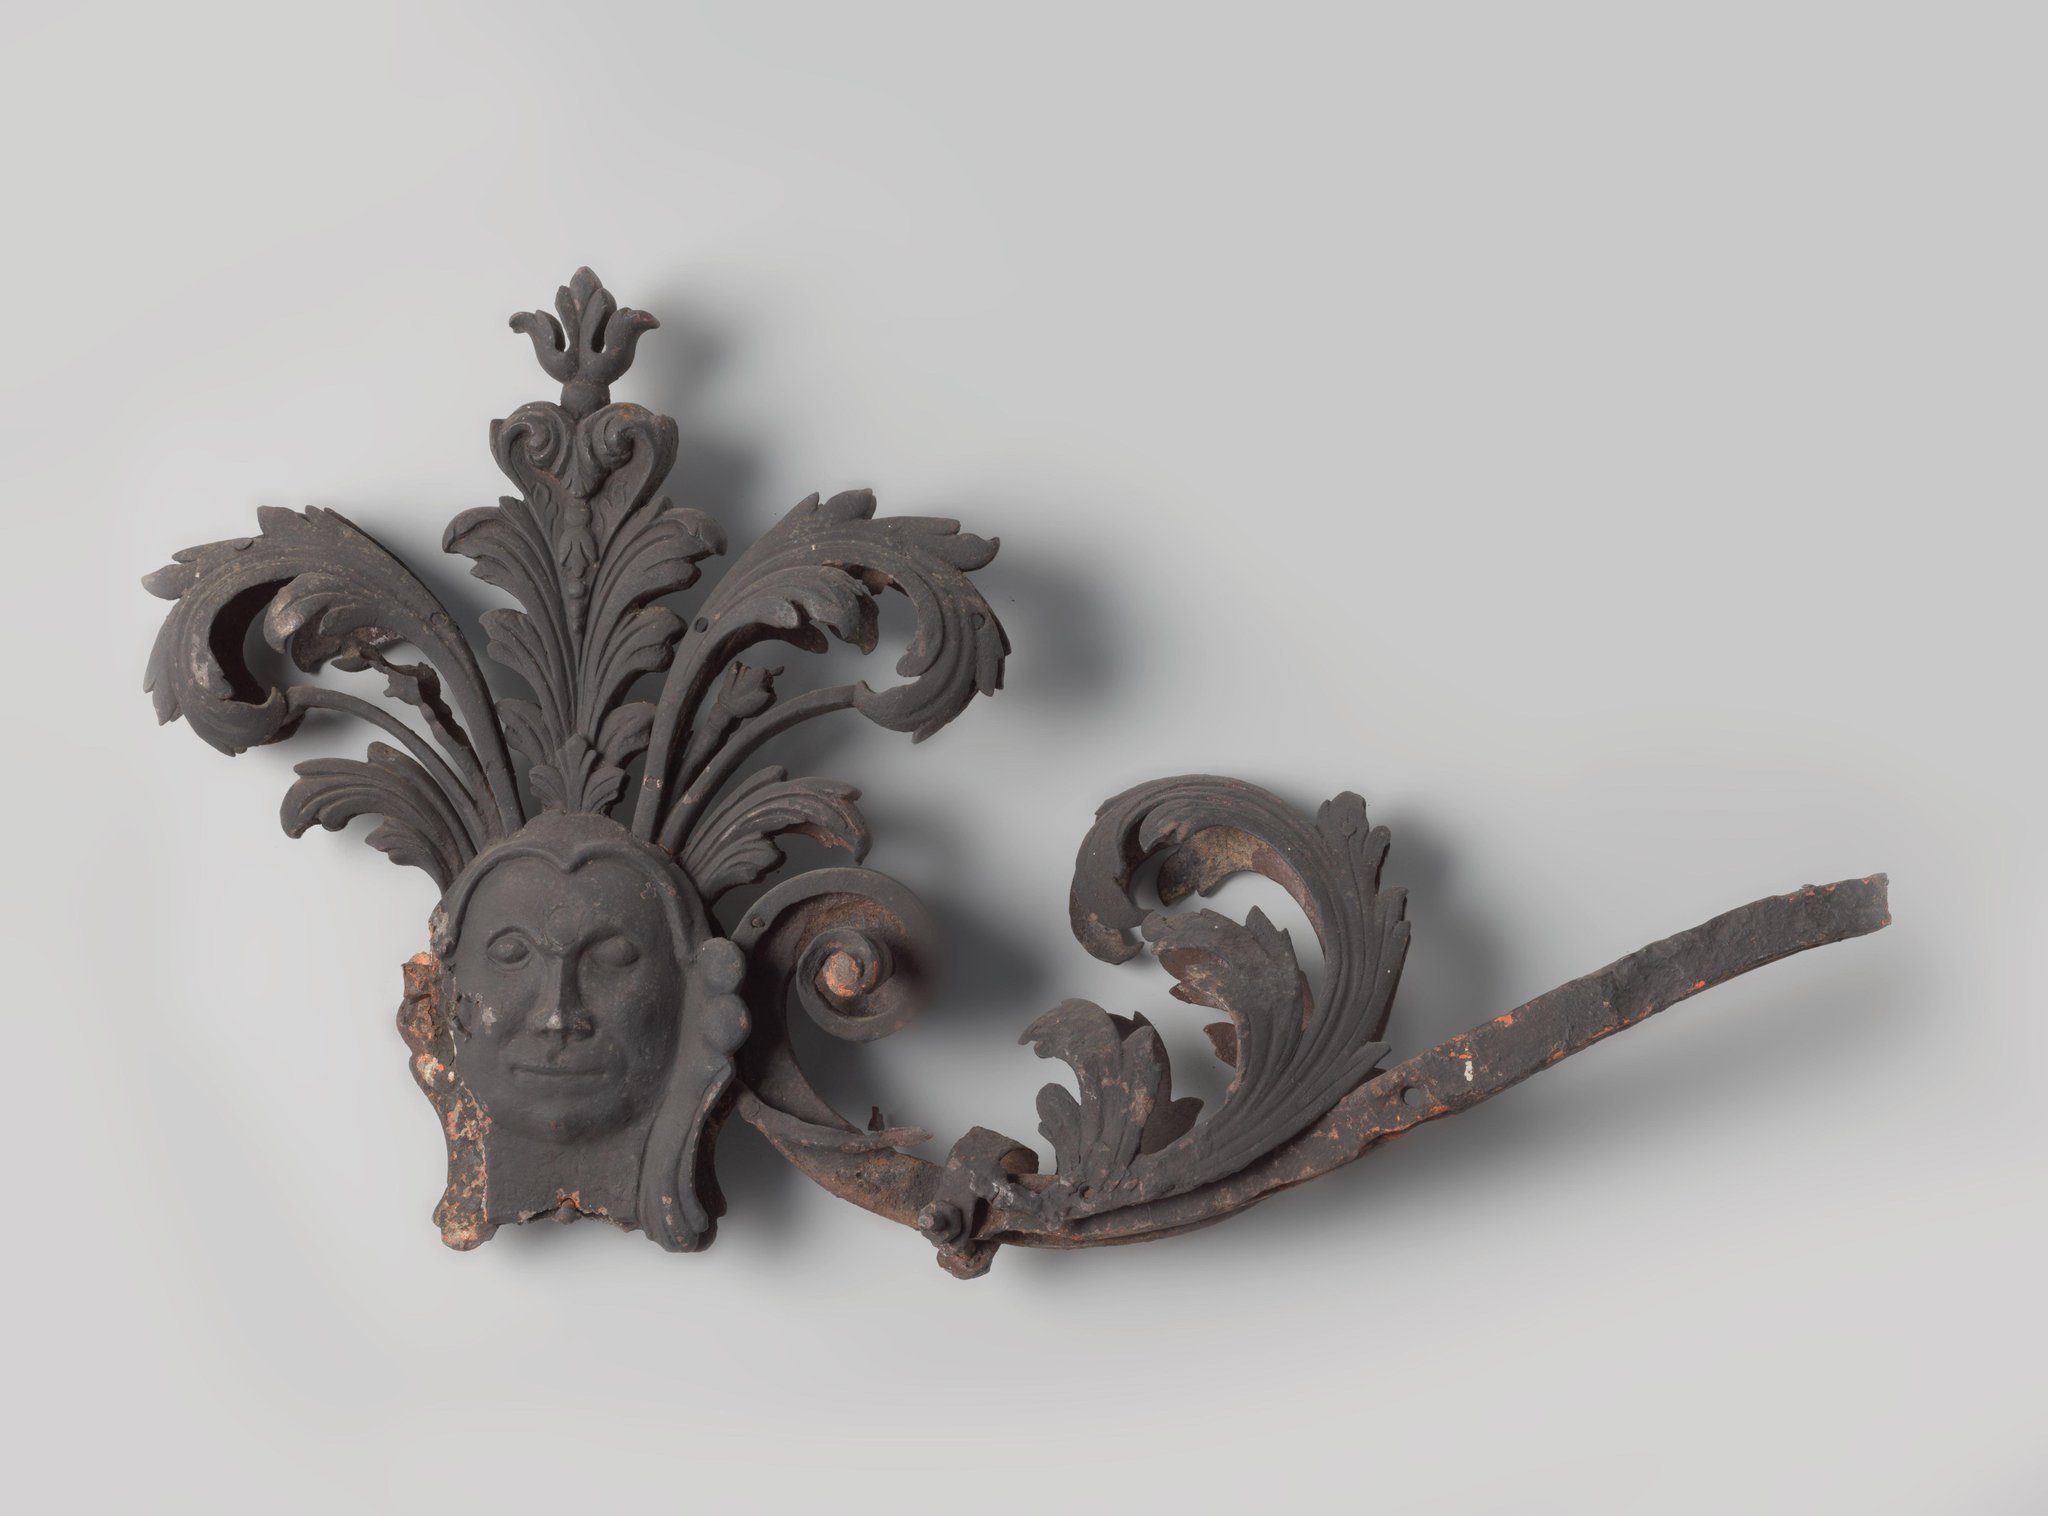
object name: uithangteken, uithangbord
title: Ornament met hoofd en acanthusbladeren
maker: Anonymous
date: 1700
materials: iron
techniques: forging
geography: amsterdam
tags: amsterdam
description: Ornament met hoofd en acanthusbladeren. Onderdeel van een uithangteken van een smederij in de Beulingstraat te Amsterdam.